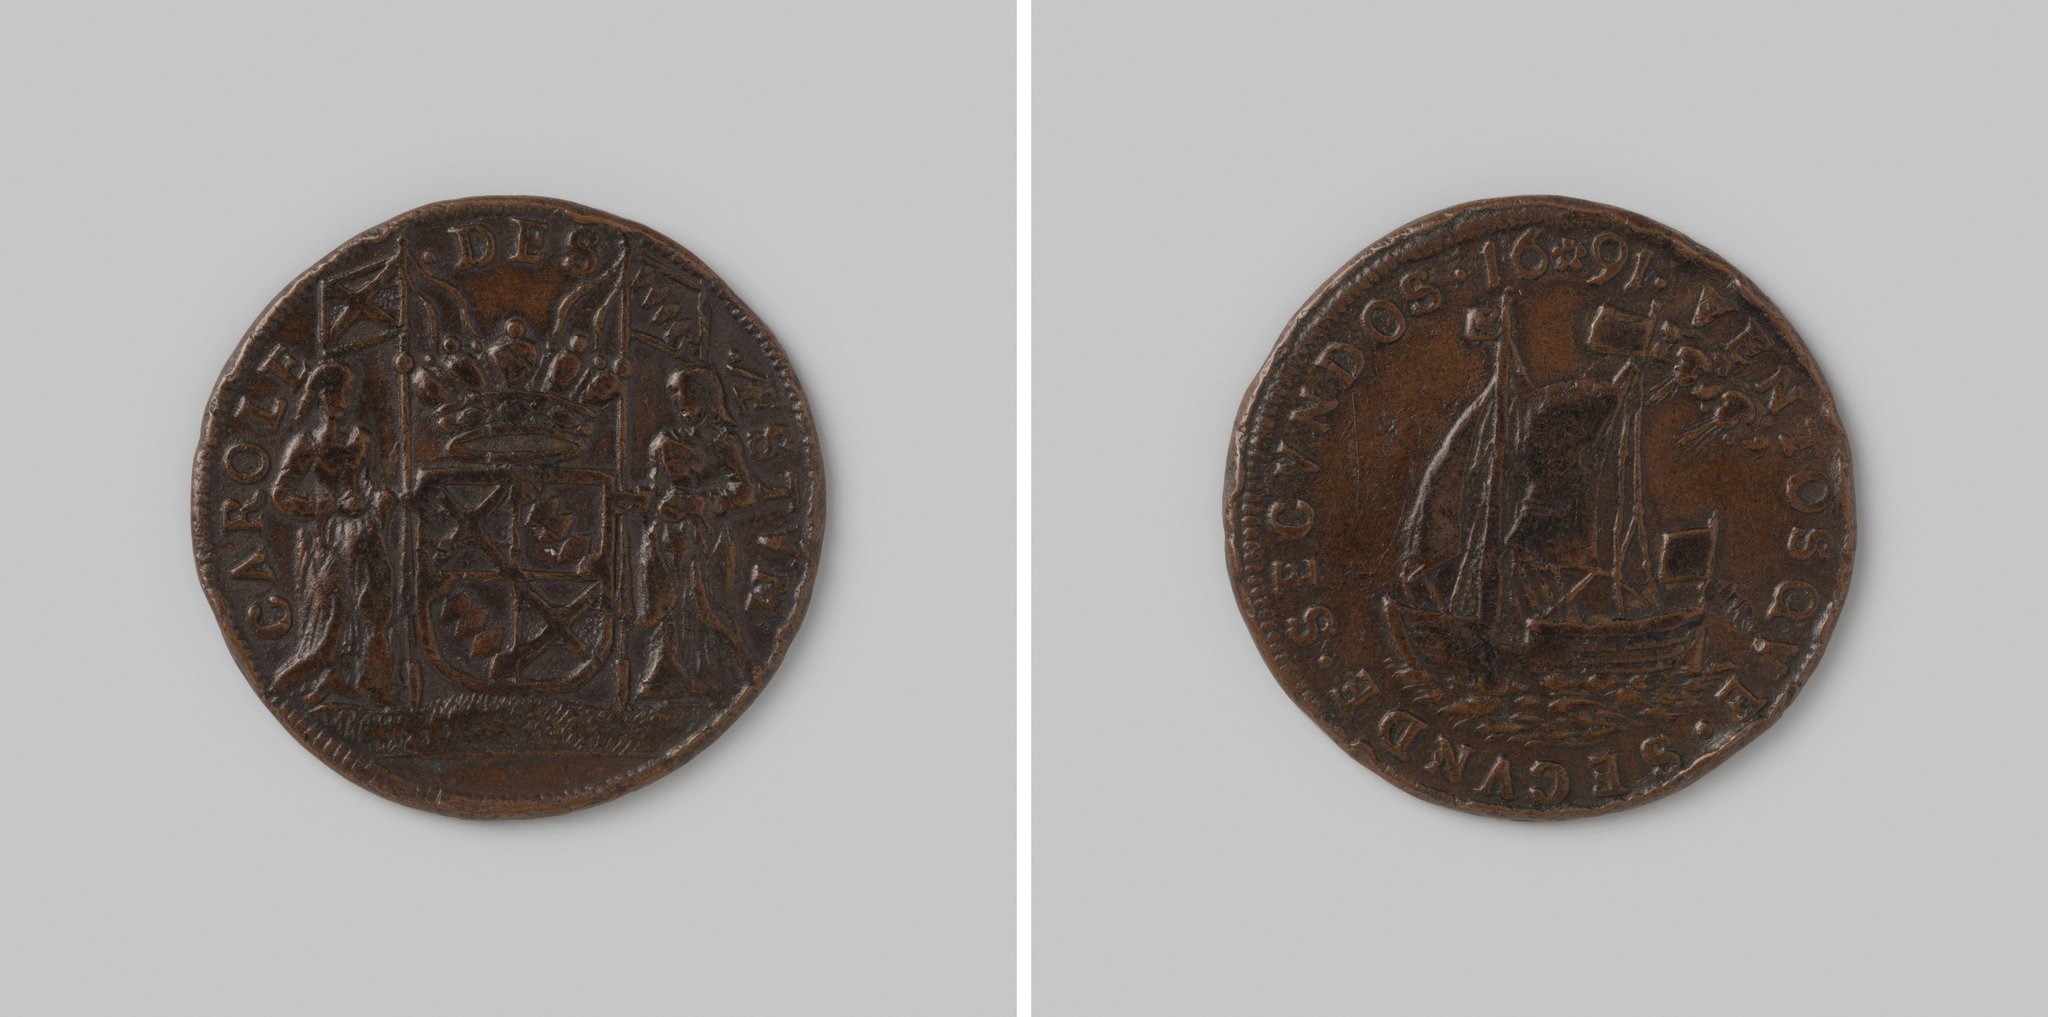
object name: history medal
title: Rekenpenning voor Willem van Hamme tresorier van Brusse 1691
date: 1691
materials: copper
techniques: striking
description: Koperen penning, op de voorzijde een gekroond wapenschild, met vrouwen met vaandels als dragers, met omschrift, op de keerzijde zeilschip voor de wind, met omschrift.